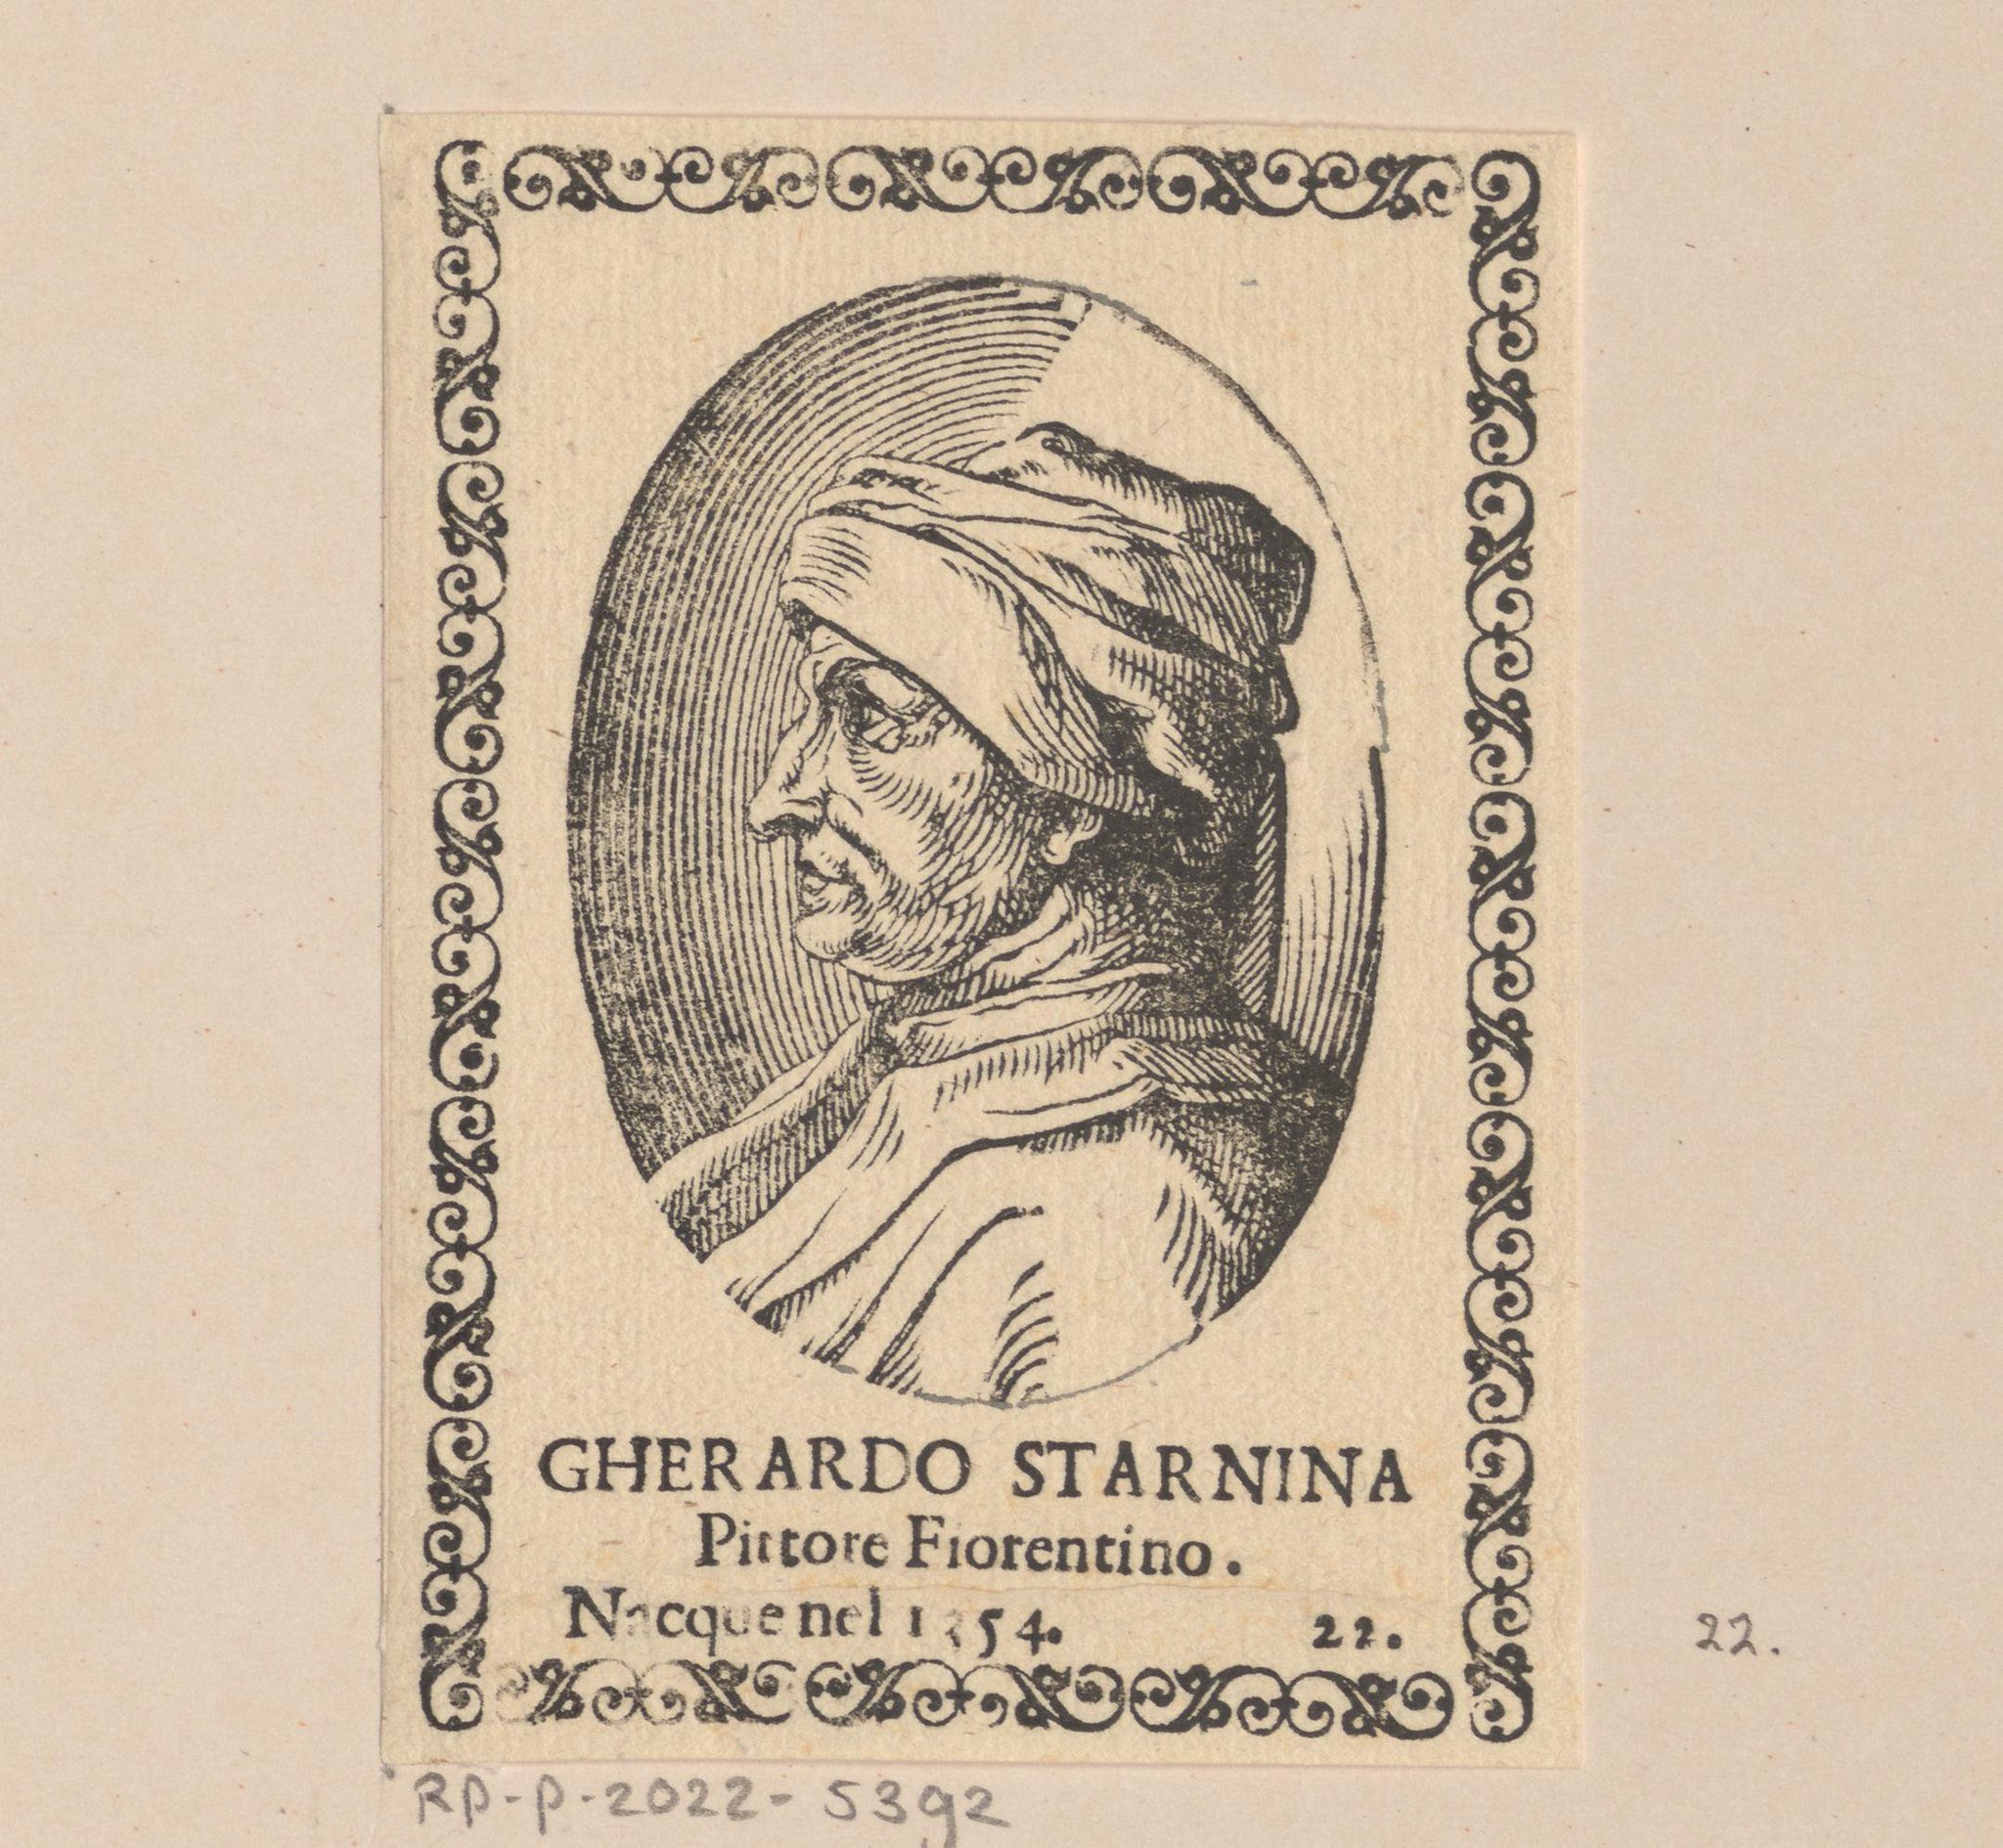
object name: print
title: Portret van Gherardo Starnina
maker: cristoforo coriolano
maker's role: print maker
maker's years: 1540-1610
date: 1568-1650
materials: paper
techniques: letterpress printing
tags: painter, gherardo starnina, historical persons, portrait, self-portrait of artist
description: Prent komt uit een editie van Vasari's 'Vite'. Prent met een andere omlijsting is gebruikt in de editie uit 1568: Vasari, Giorgio. Le vite de' piu eccellenti pittori scultori, e architettori. Florence: Filippo Giunta, 1568. En mogelijk in de editie uit 1647.